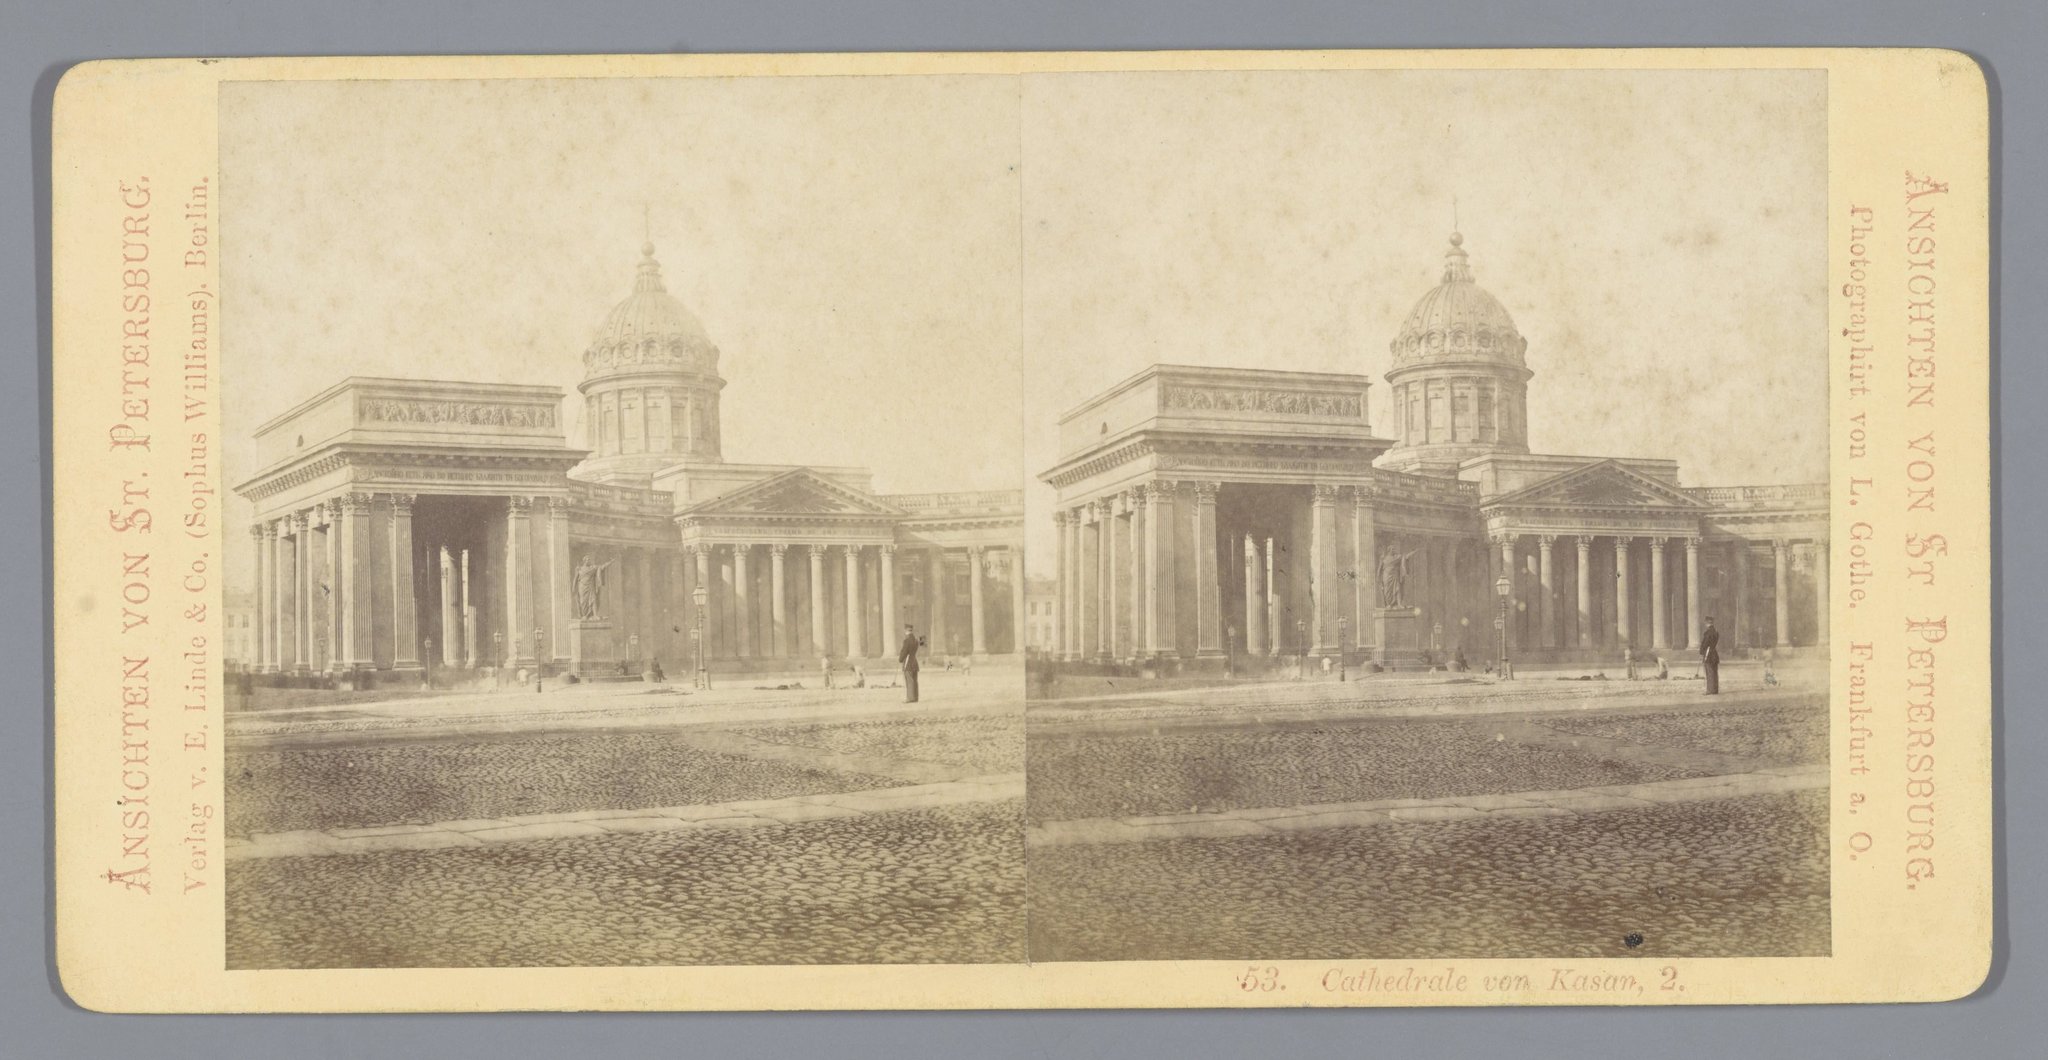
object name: stereograph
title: Cathedrale von Kasan, 2.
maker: louis gothe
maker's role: fotograaf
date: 1850-1880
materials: cardboard, photographic support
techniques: albumen print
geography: sint-petersburg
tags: colonnade, church (exterior), dome ~ architecture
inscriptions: number: ‘53.’, inscription: ‘Ansichten von St. Petersburg.’